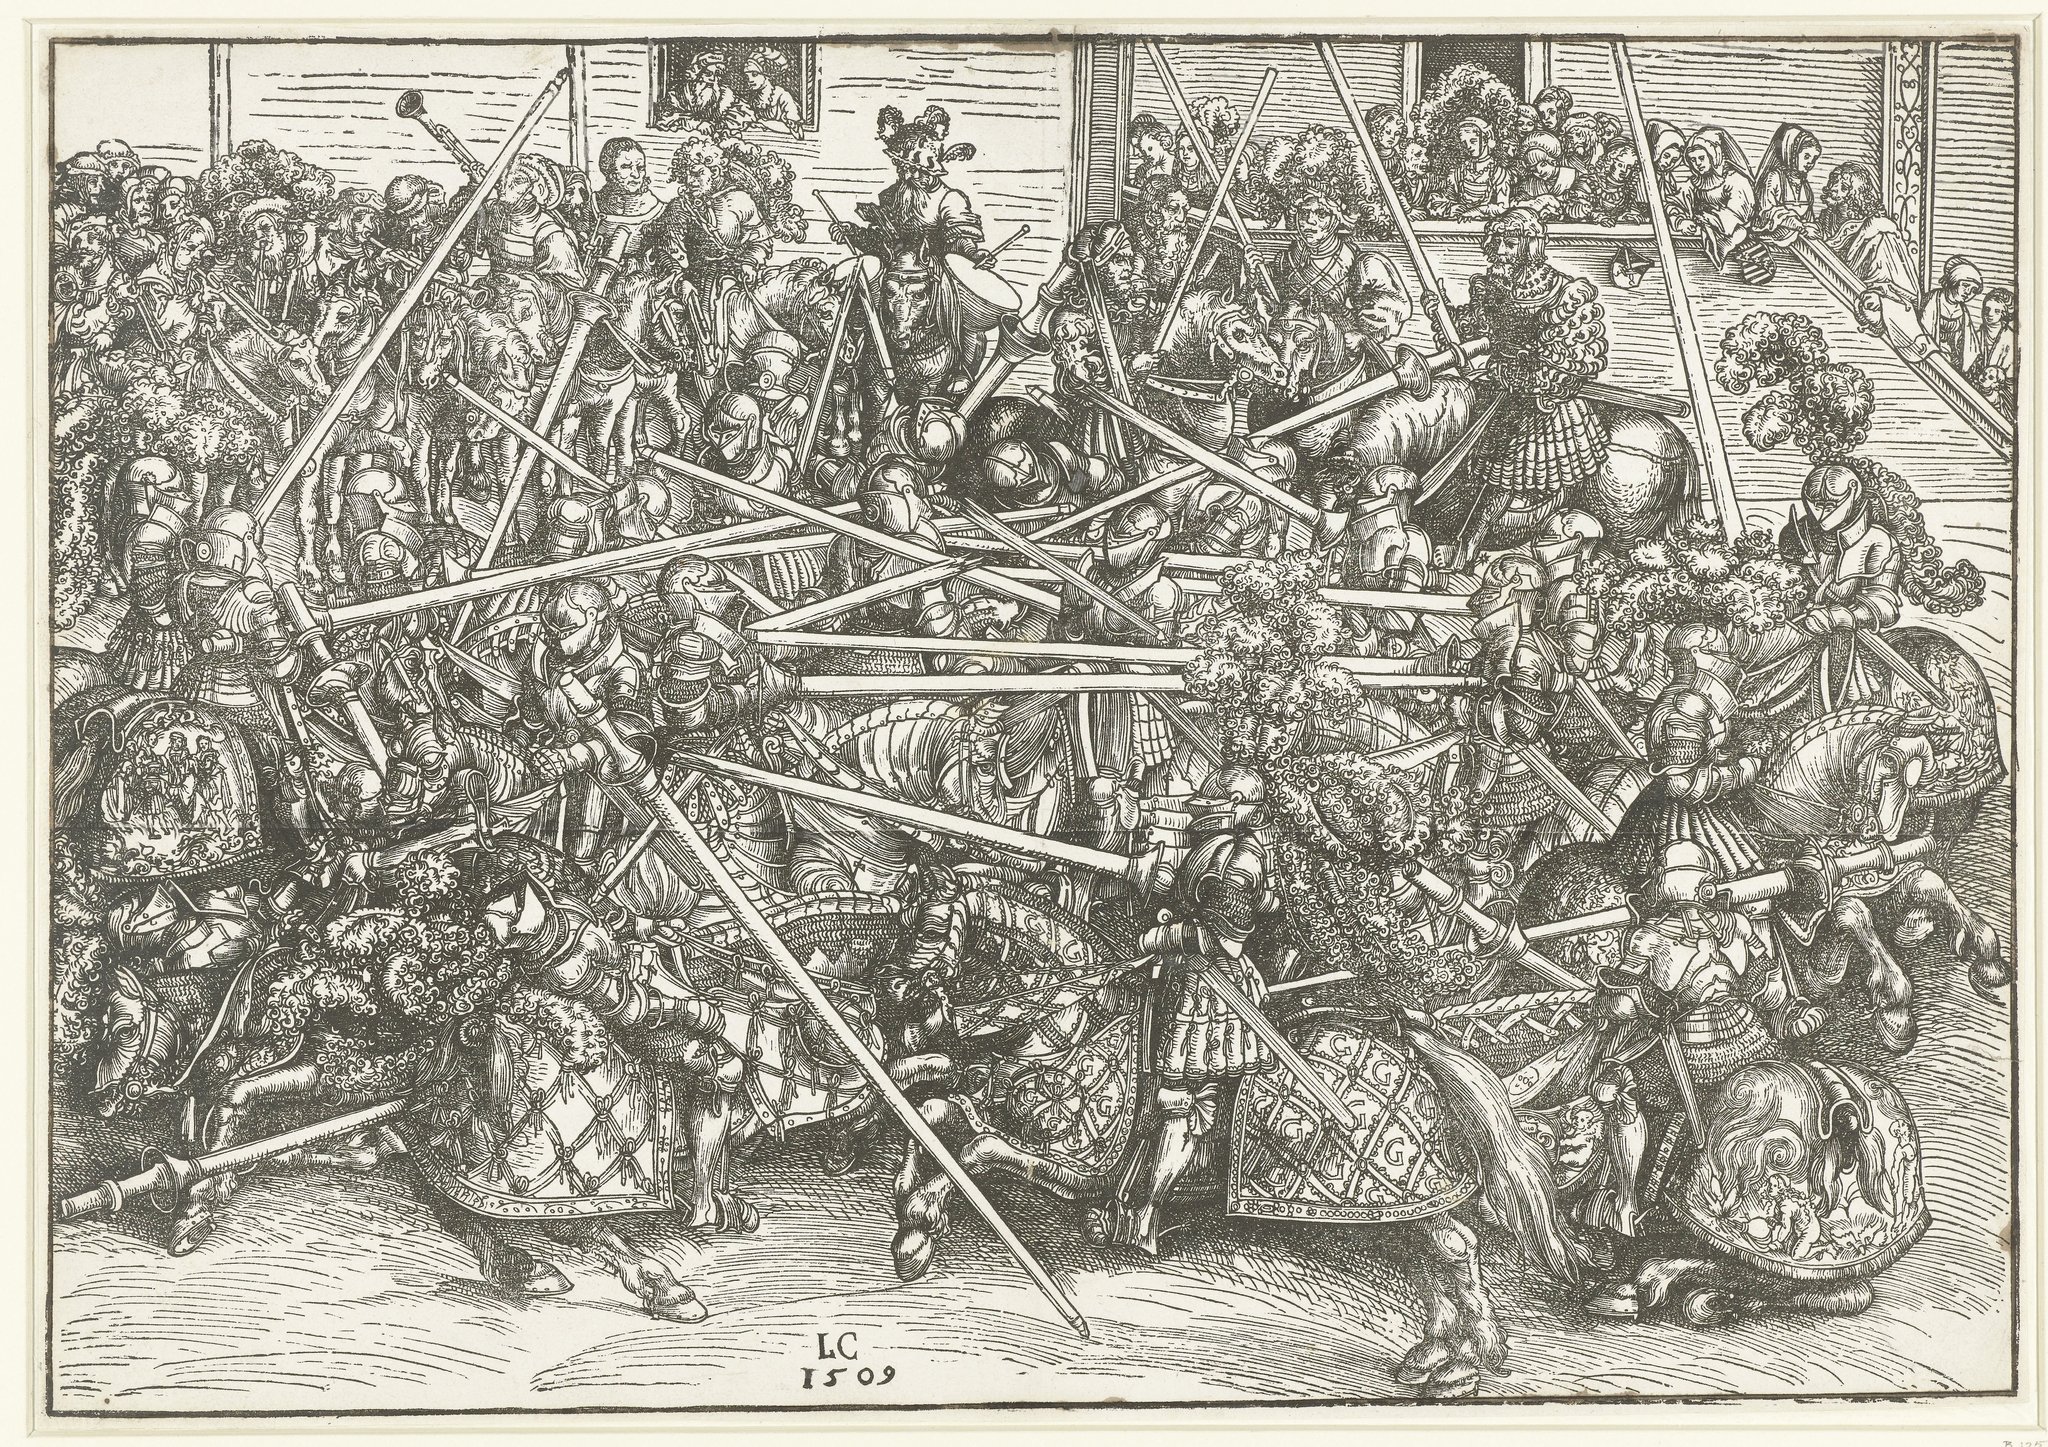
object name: print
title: Toernooi in Wittenberg van het keurvorstelijk hof van Saksen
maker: lucas cranach (i)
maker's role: draughtsman, print maker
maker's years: 1472-1553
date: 1509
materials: paper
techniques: woodcut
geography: wittenberg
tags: tournament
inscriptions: collector's mark: Lugt 240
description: Toernooi in Wittenberg georganiseerd door het hof van Saksen. Ridders te paard rijden op elkaar in terwijl ze met lansen proberen hun tegenstander uit het zadel te werken. Linksachter staat een groep muzikanten, gezeten op paarden, te blazen op trompetten en te slaan op trommels. Op een balkon staat de adel als toeschouwer. Twee schilden tegen de wand tonen het hertogelijk en het keurvorstelijk wapen van Saksen.